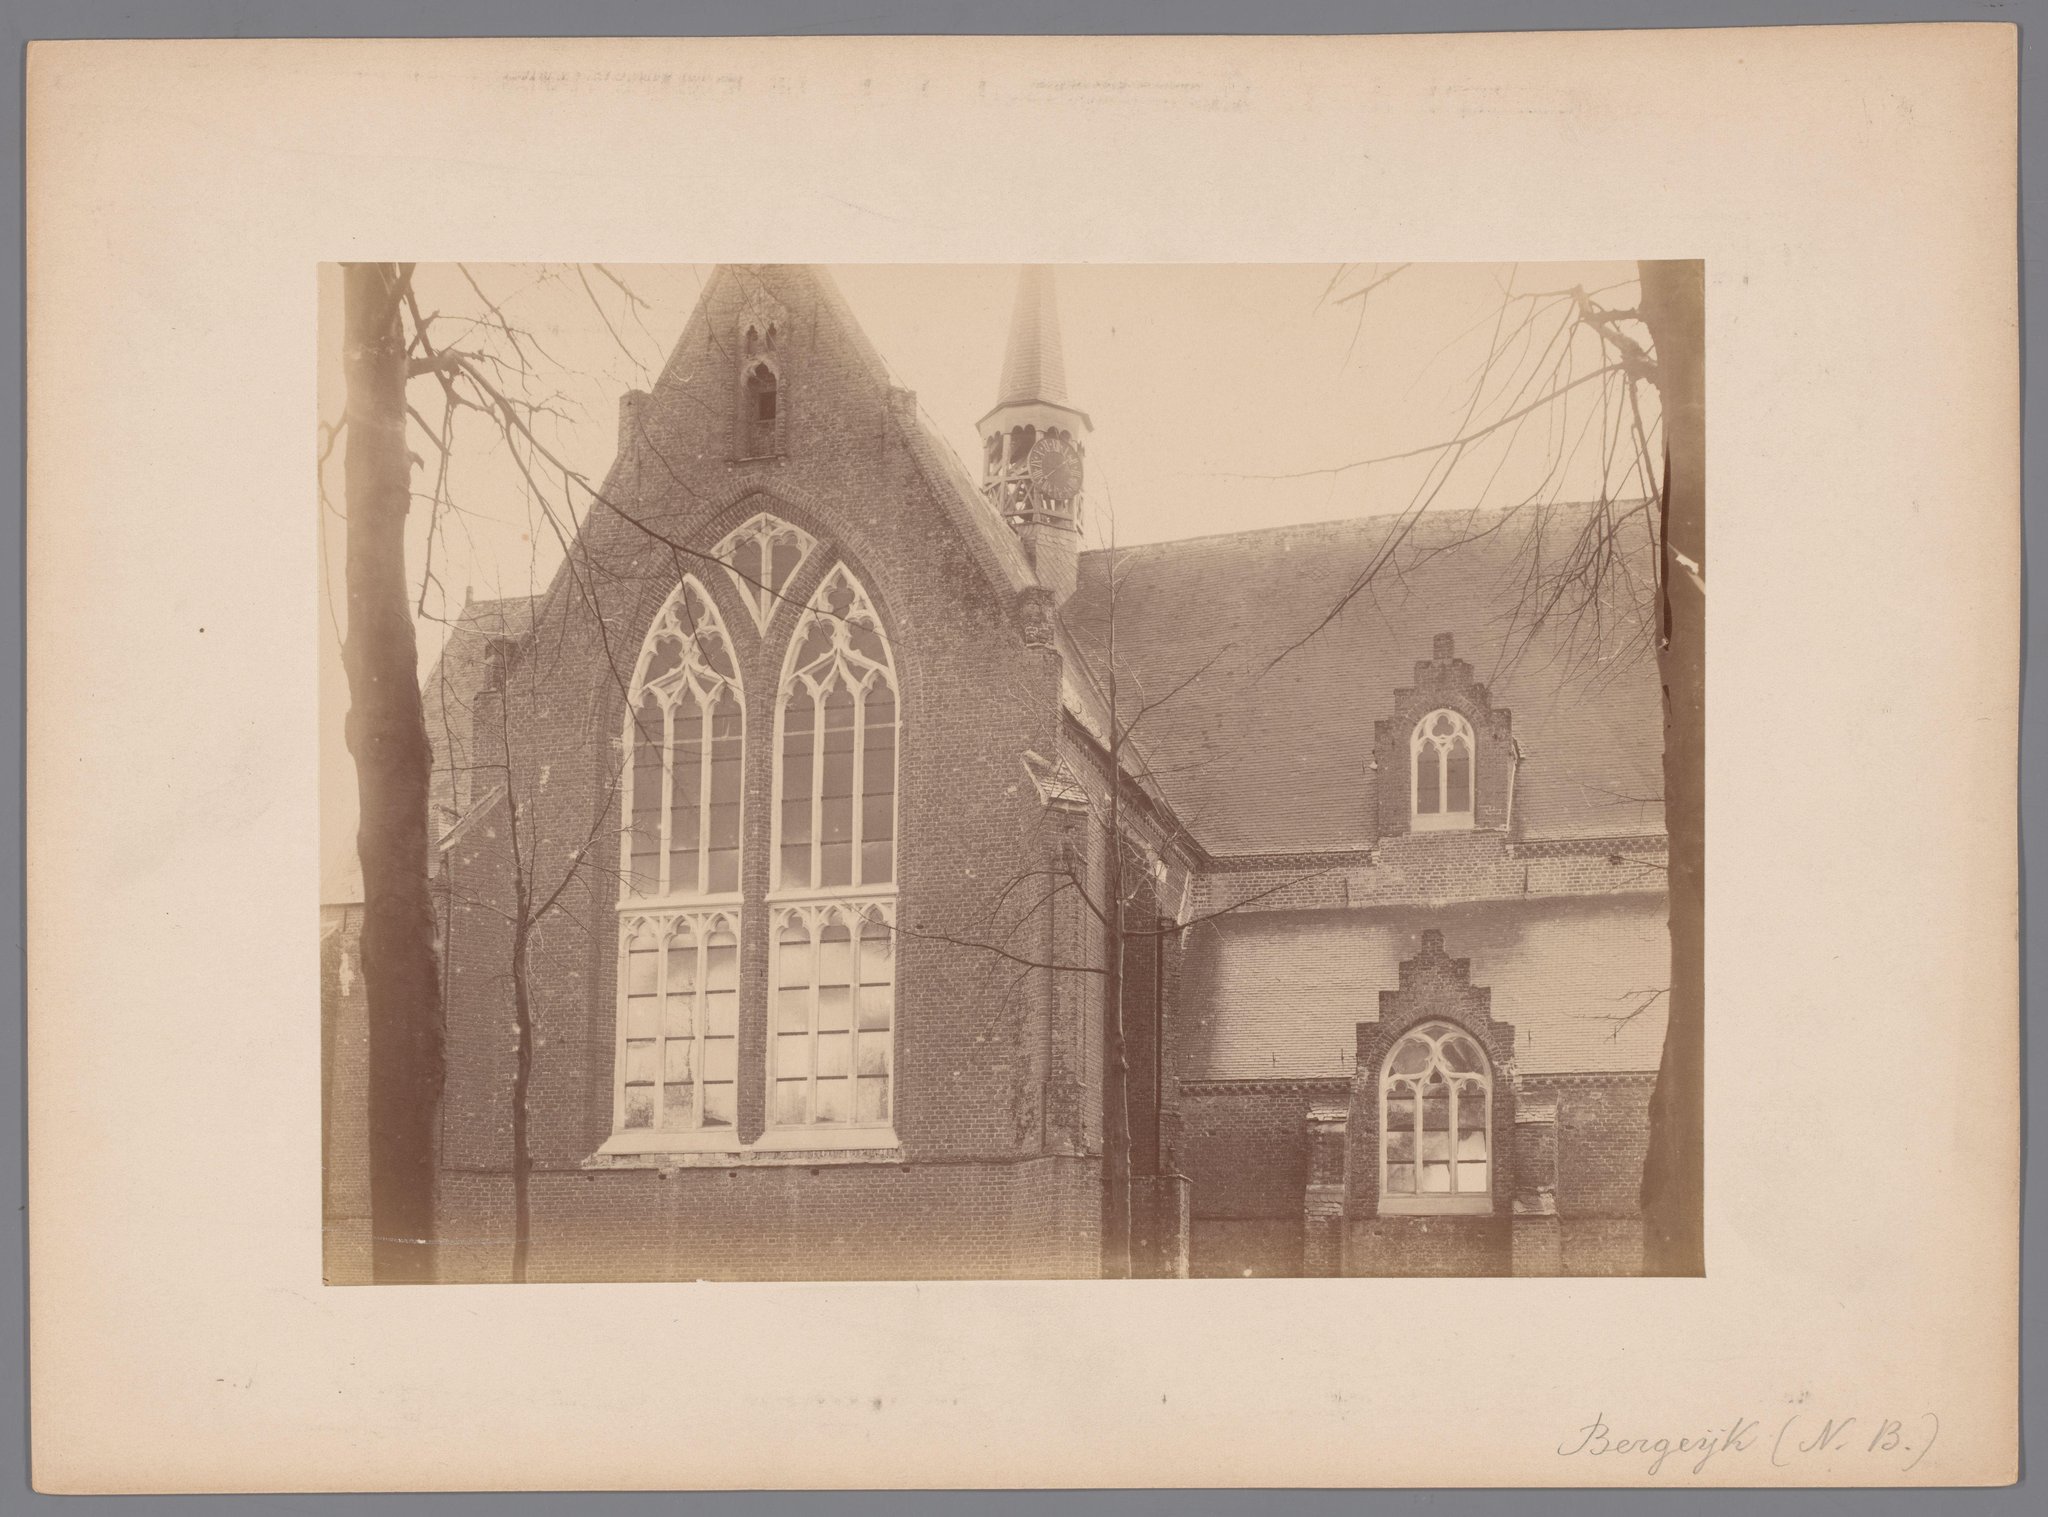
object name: photograph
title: Noordzijde van St. Petrus' Bandenkerk of Hofkerk te Bergeijk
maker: anoniem (monumentenzorg)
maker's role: fotograaf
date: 1890-1920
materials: cardboard, photographic support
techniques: albumen print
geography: bergeijk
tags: church (exterior)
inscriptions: annotation: ‘Bergeijk (N.B.)’, annotation: ‘Bergeijk N.B./ Noordzijde kerk’